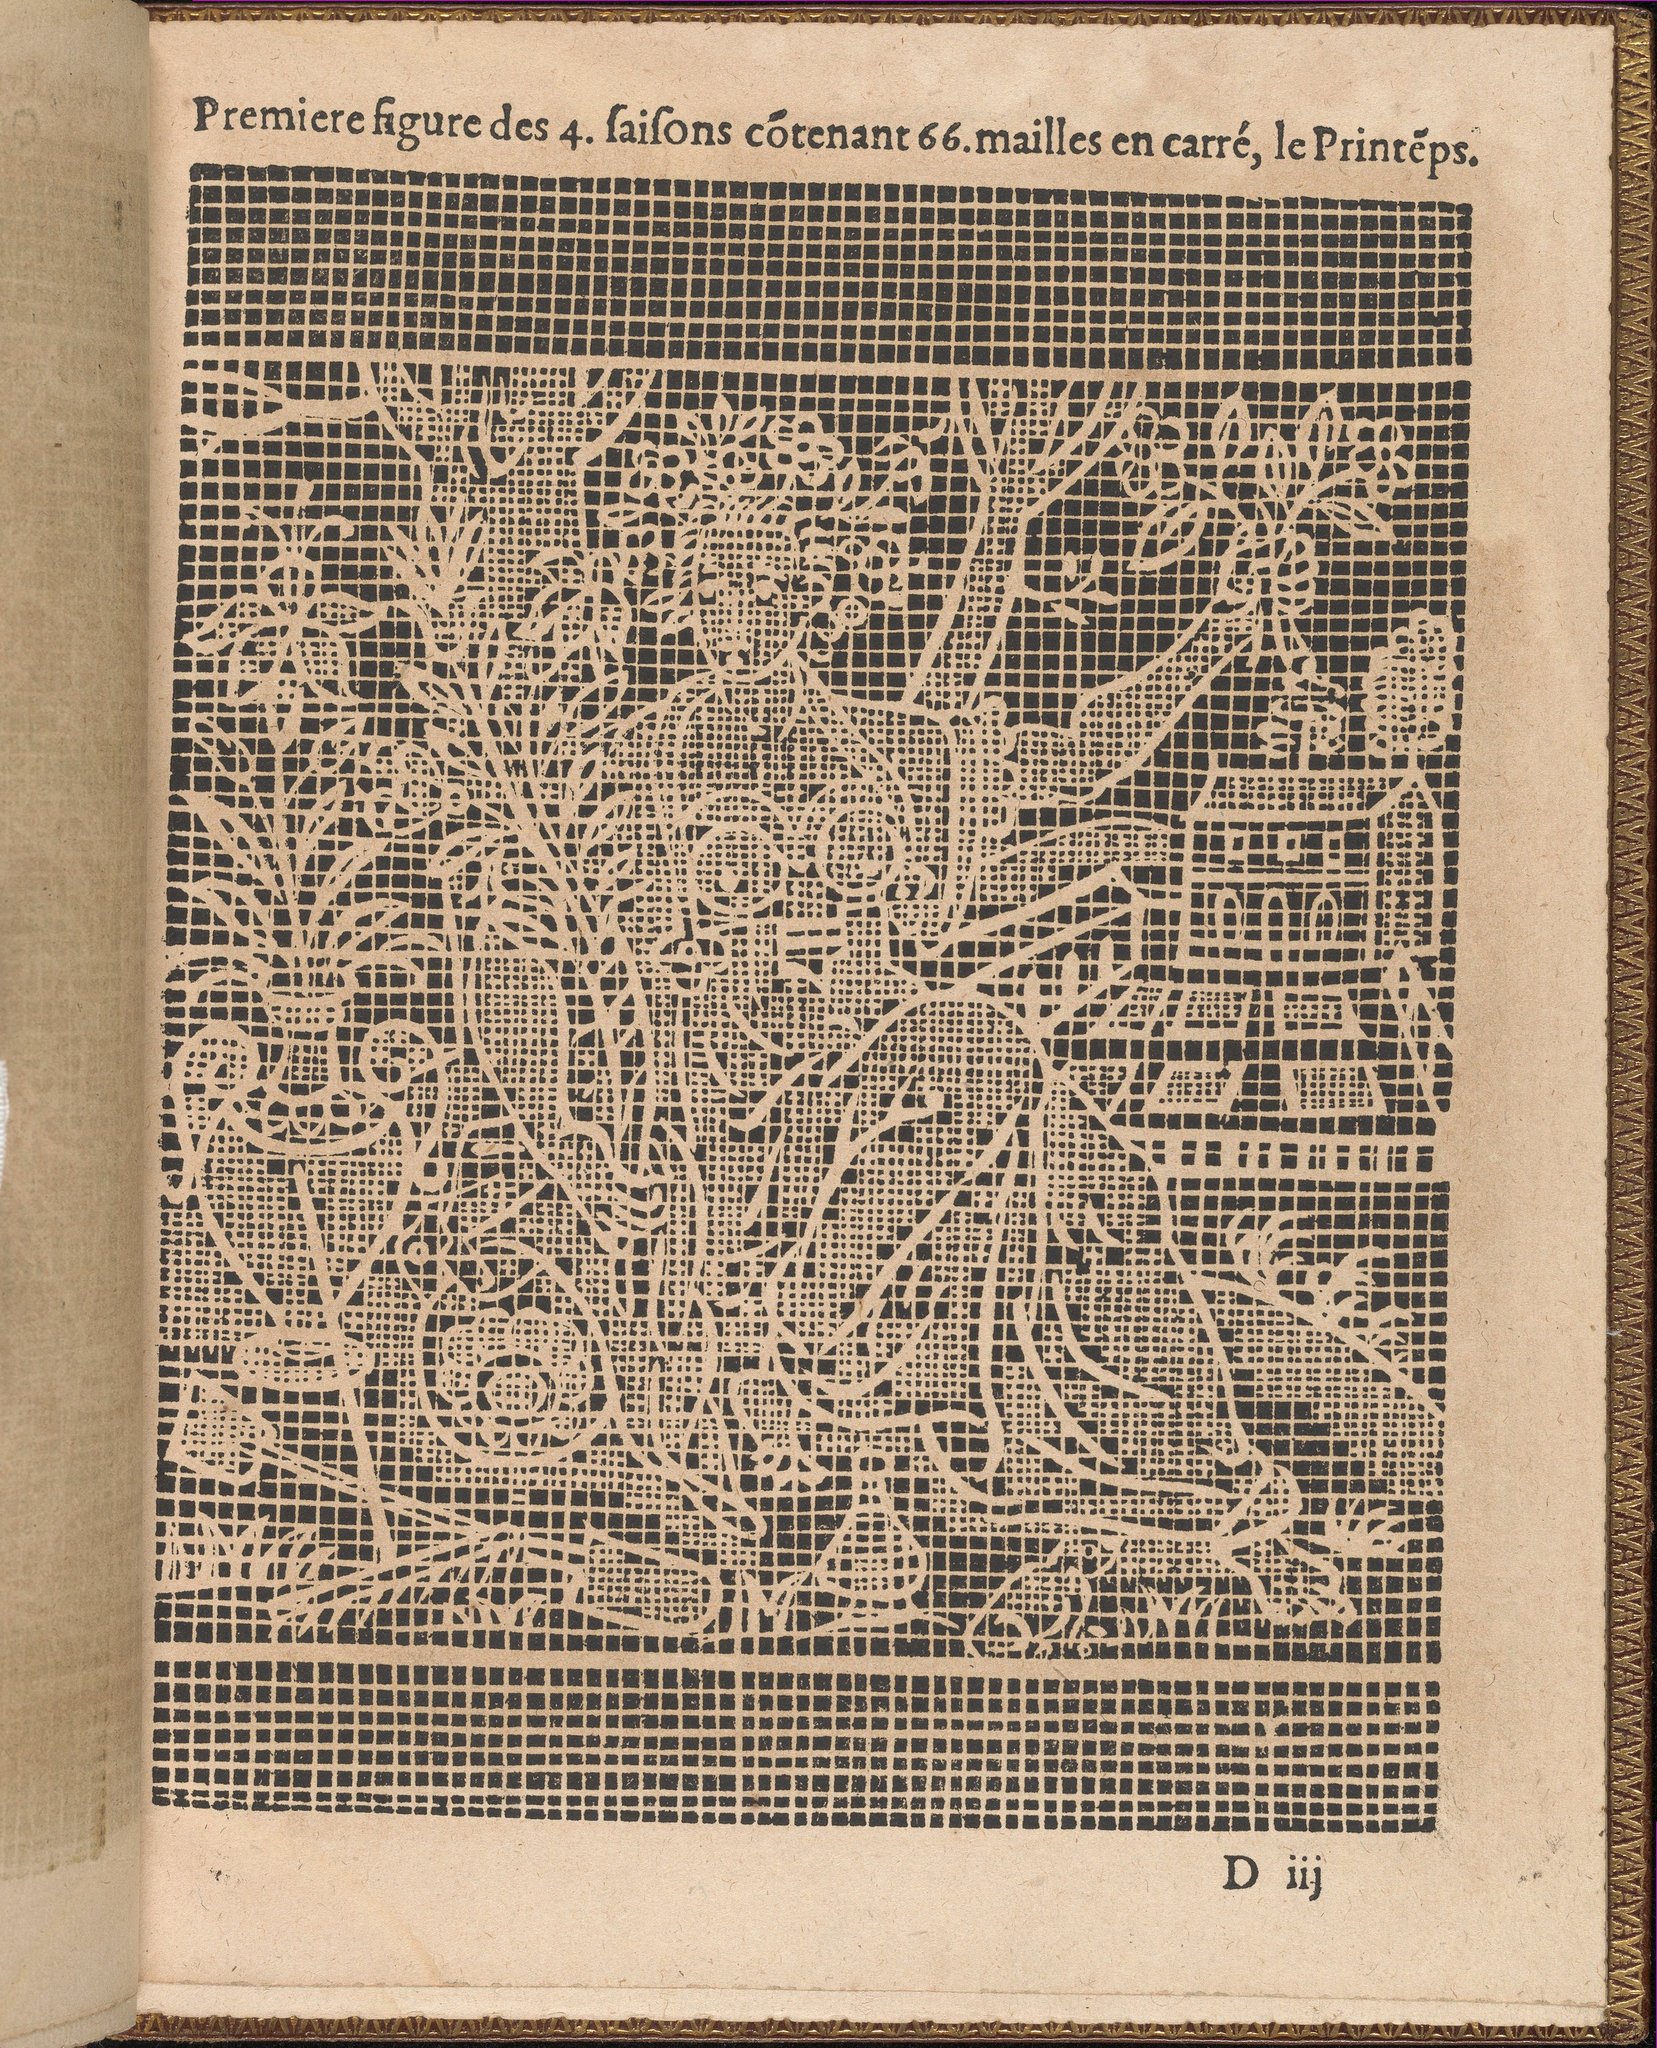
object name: book print ornament architecture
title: La Pratique de l'Aiguille, page 14 (recto)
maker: matthias mignerak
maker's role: author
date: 1605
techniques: woodcut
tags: women,flowers